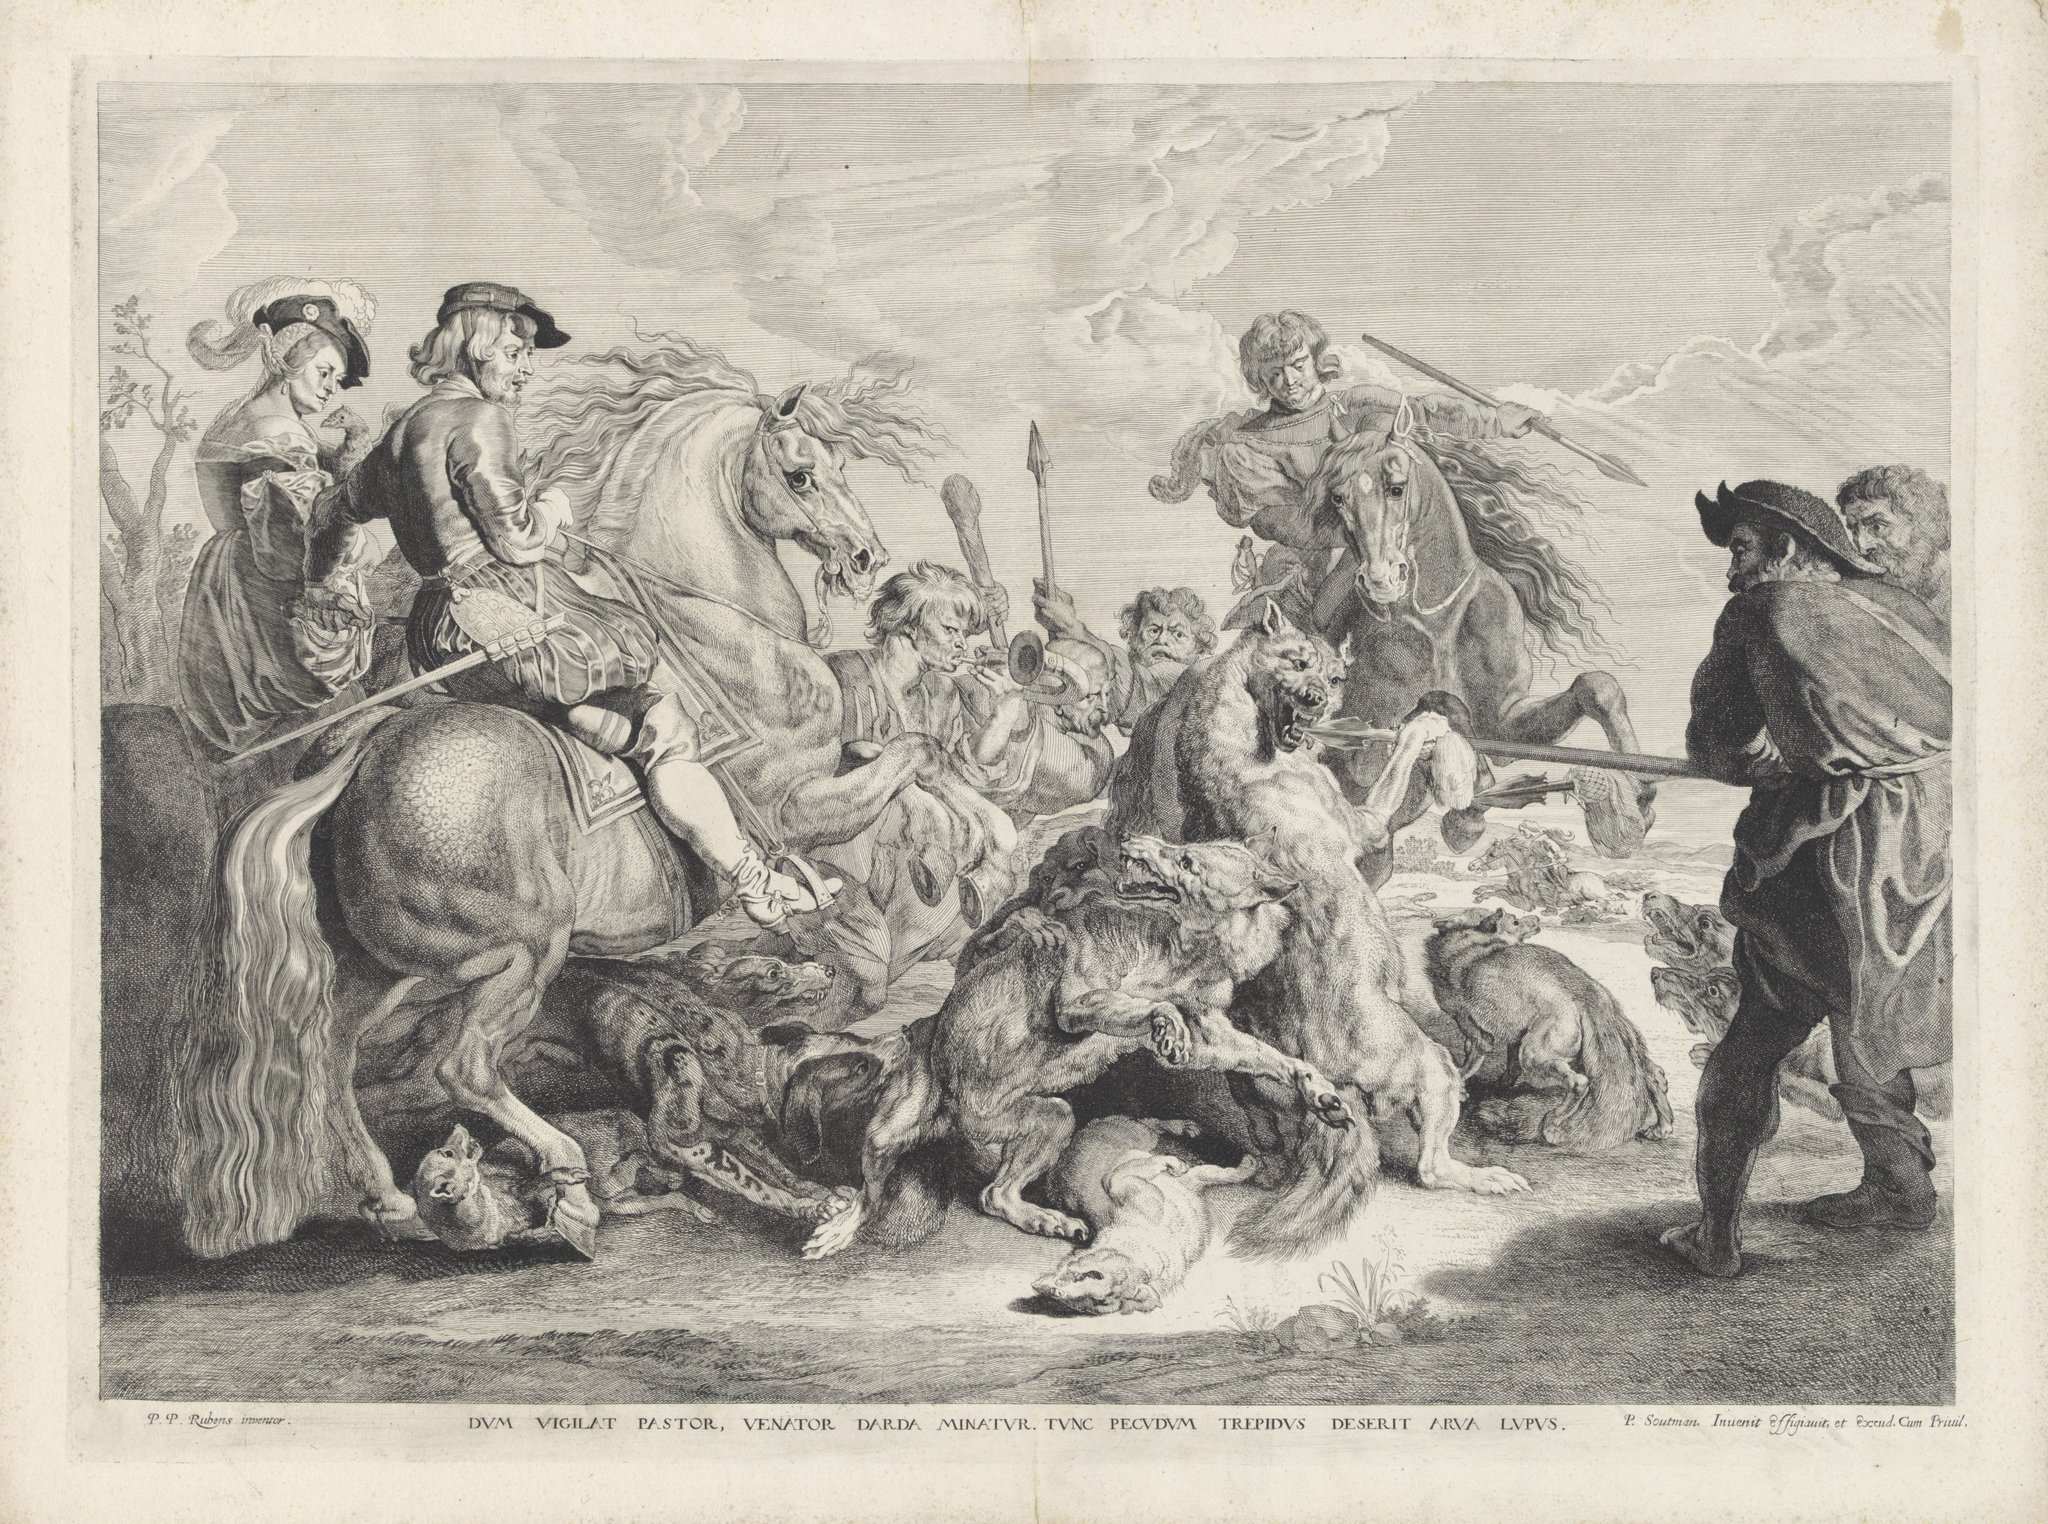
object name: print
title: Wolvenjacht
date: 1644-1650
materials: paper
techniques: engraving, etching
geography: haarlem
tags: riding a horse, ass, or mule; rider, horseman, hunting, chase, hunt ~ predatory animals (fox, lion), hunt ~ predatory animals (fox, lion) (+ hunting with dogs)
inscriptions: collector's mark: Lugt Lugt 2228